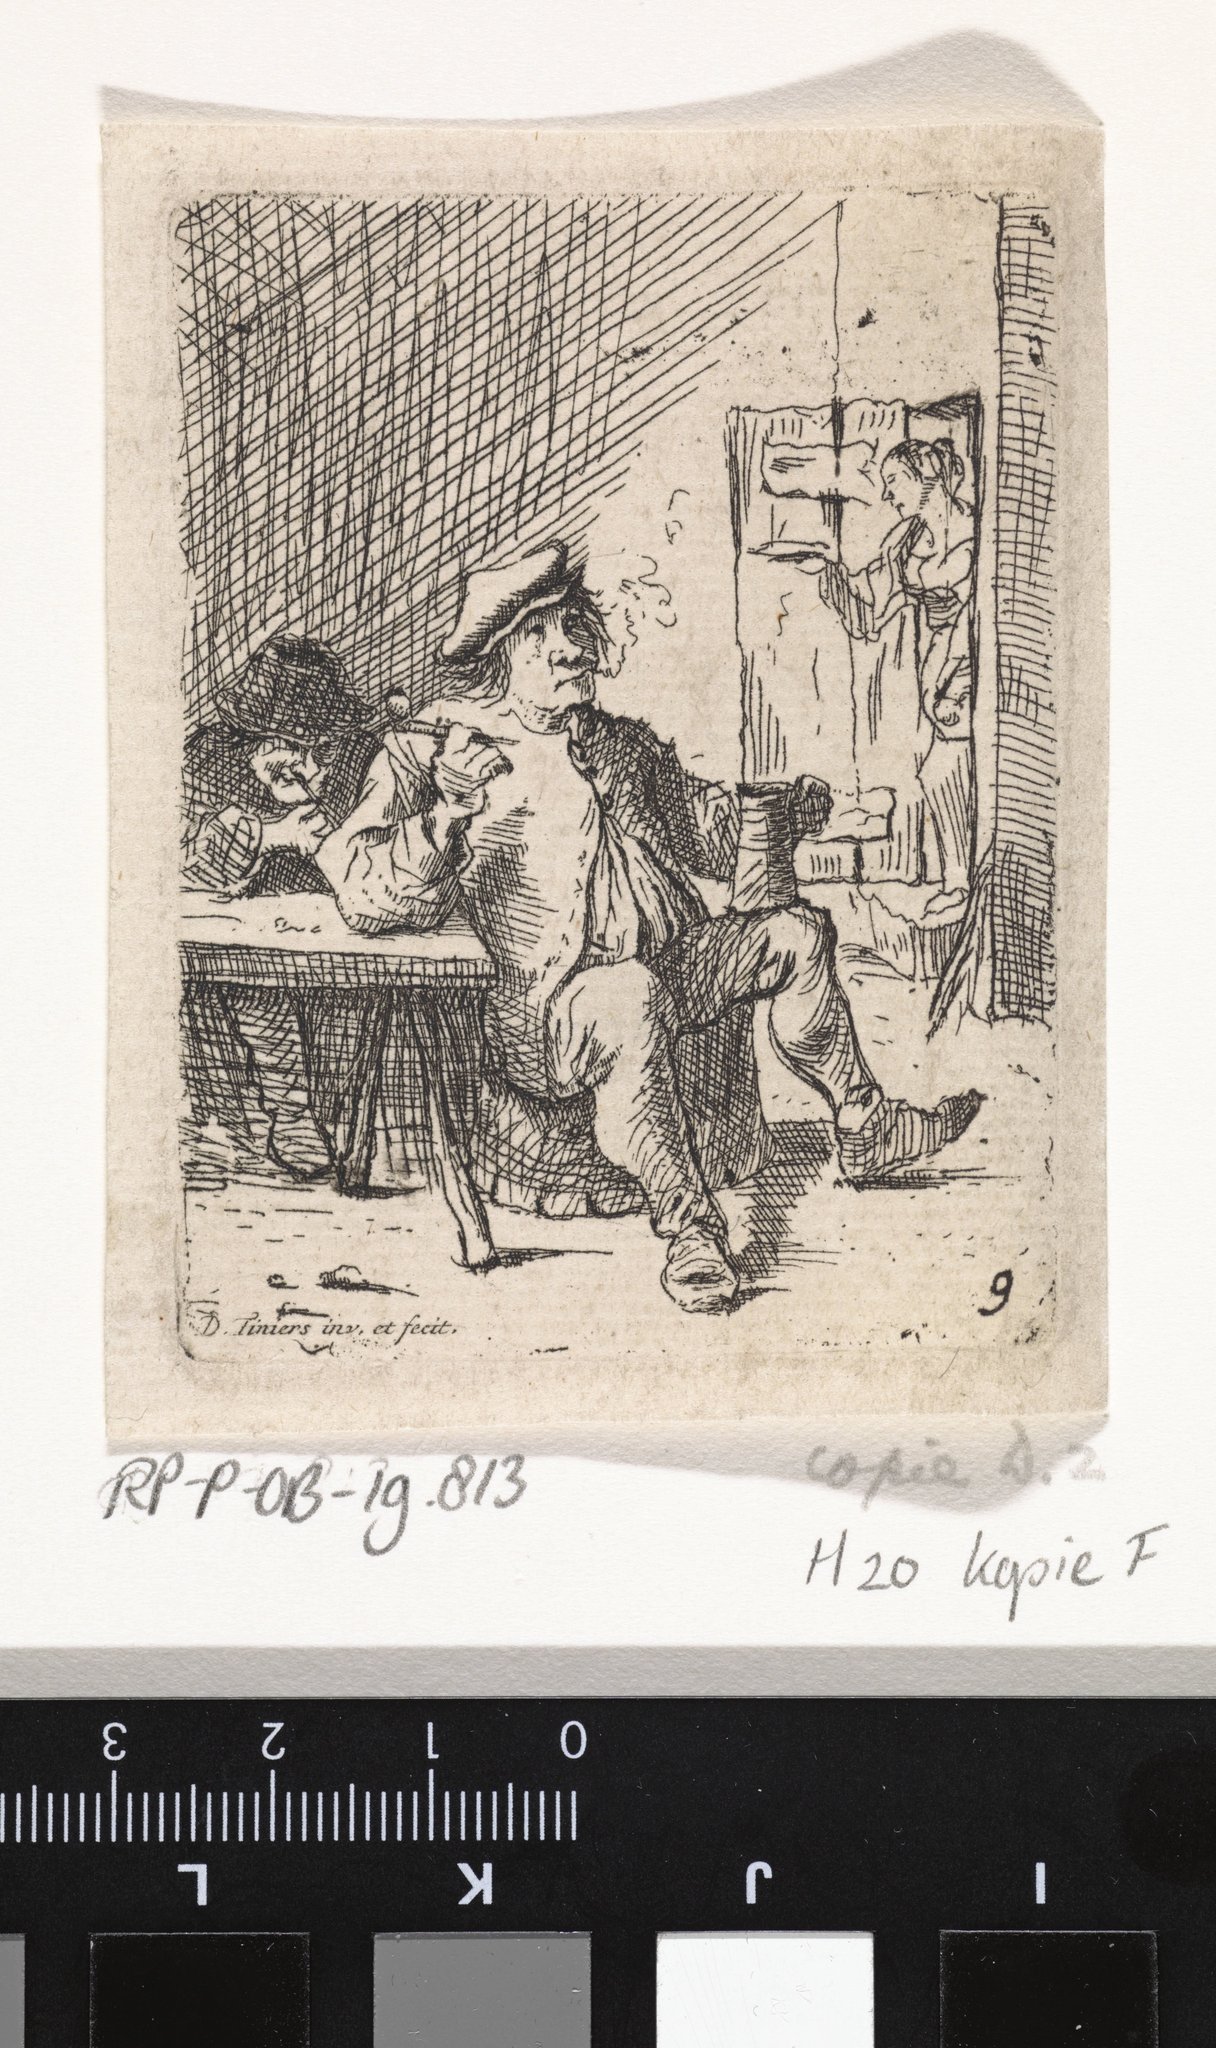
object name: print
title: Zittende boer met kruik en pijp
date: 1626-1740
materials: paper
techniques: etching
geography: netherlands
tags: pipe ~ tobacco, opening the door, drinking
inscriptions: collector's mark: Lugt 2228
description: Een boer zit rechts naast een tafel, met een kruik en een pijp in zijn handen. Achter de tafel zit een man. Rechts komt een vrouw door de deur de ruimte binnen.